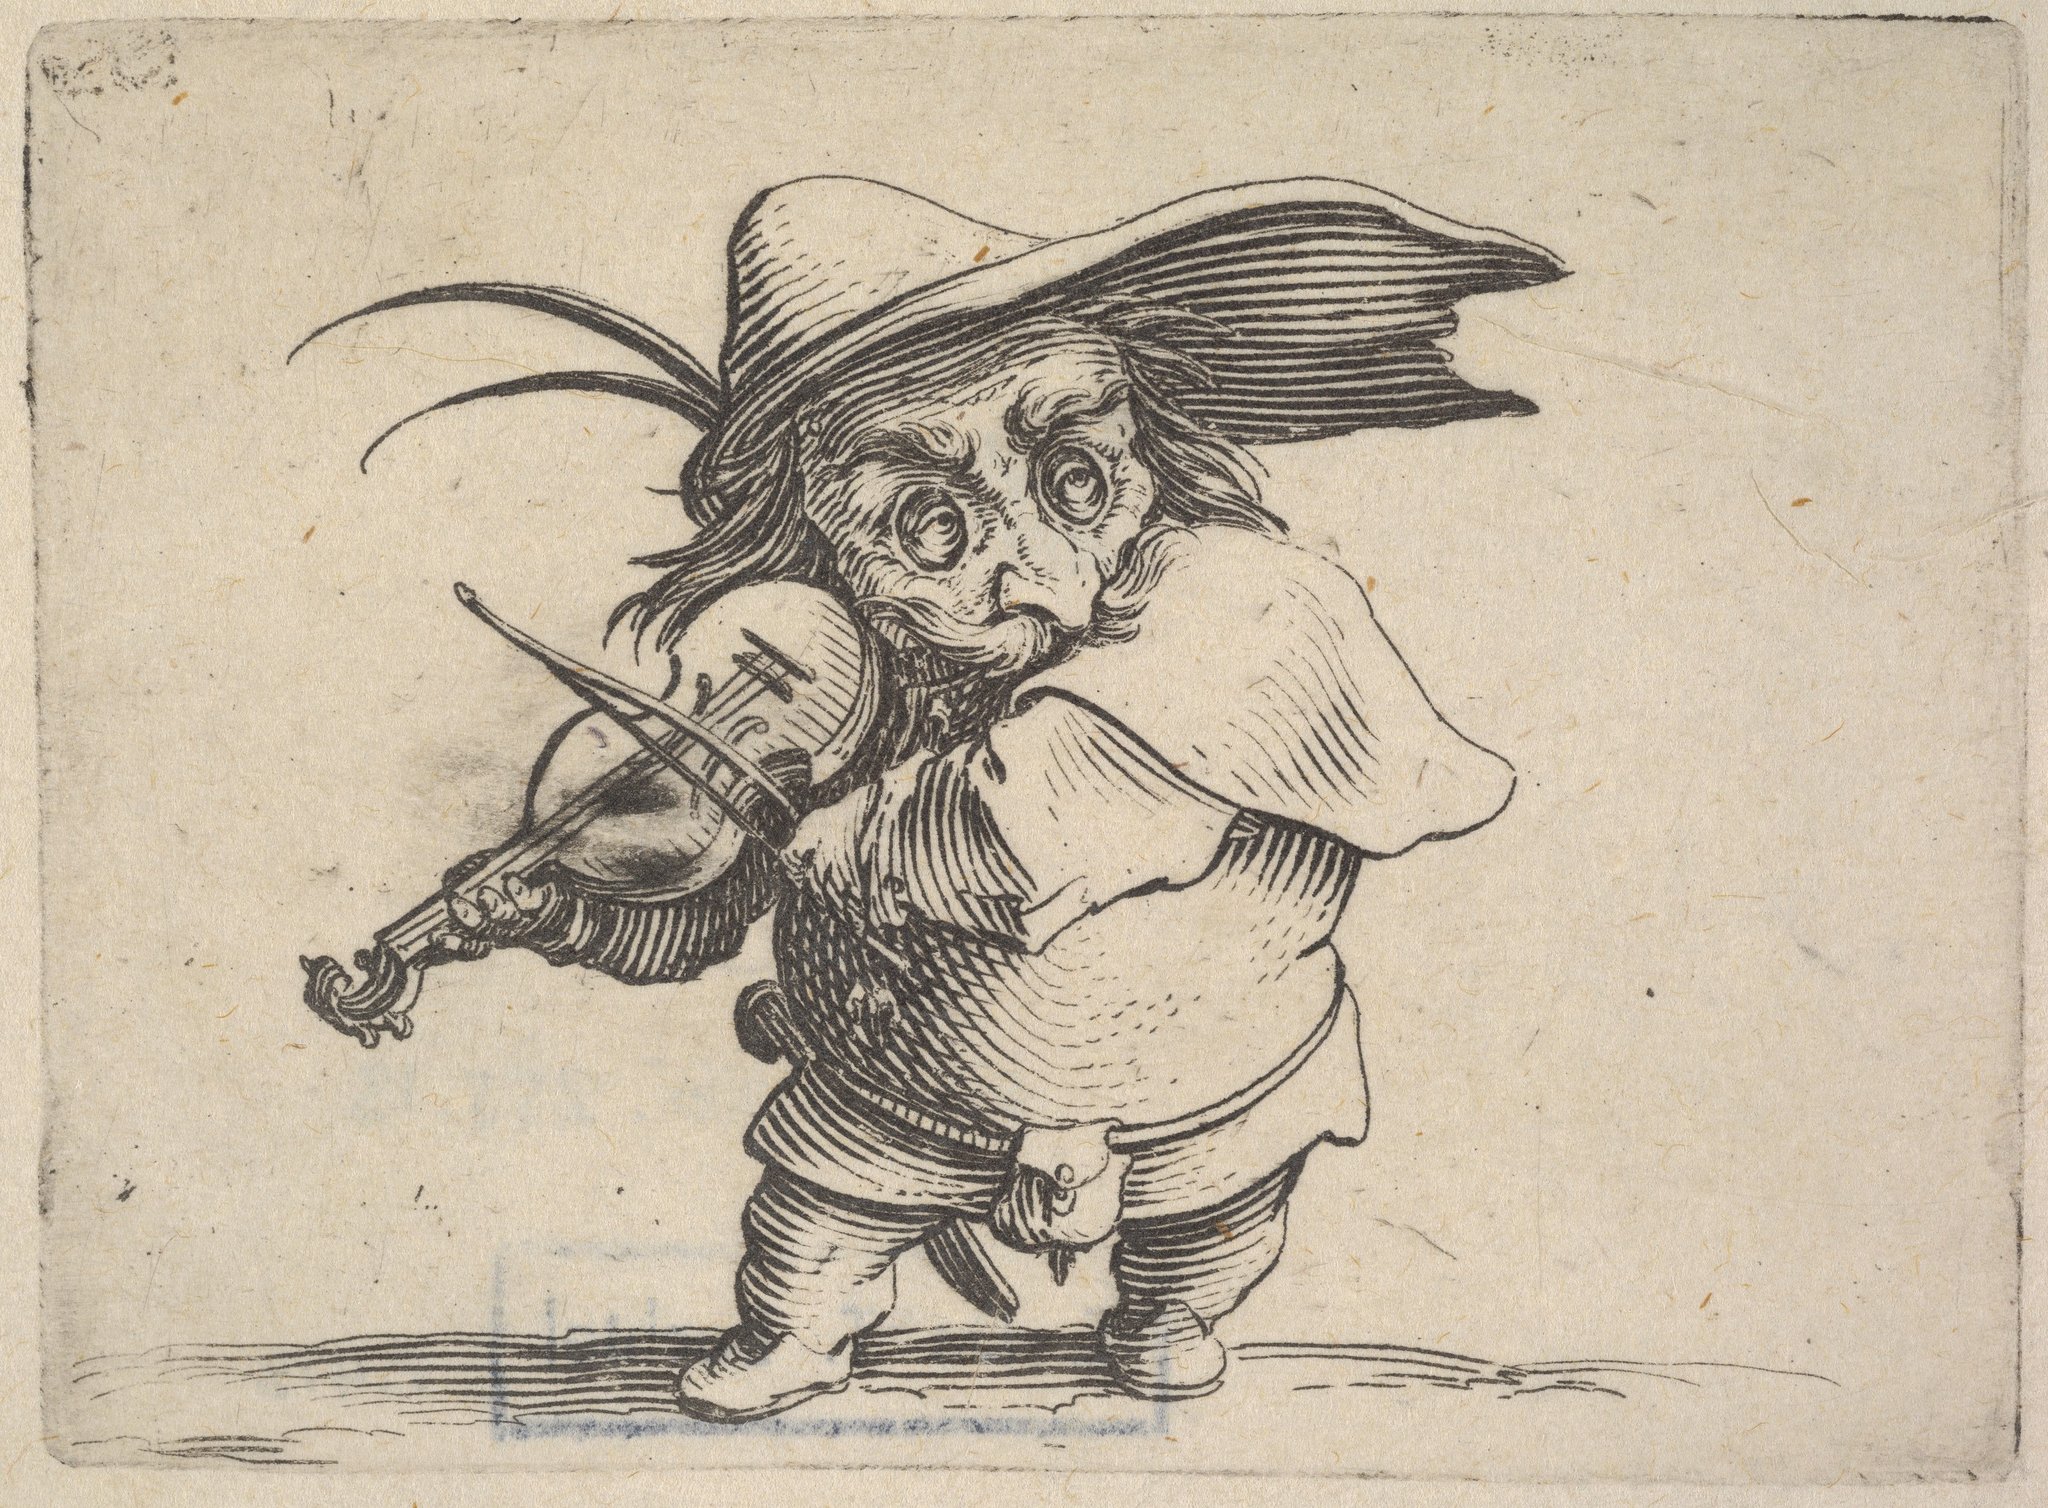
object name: print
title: Small, masked male figure playing a violin, from "Varie Figure Gobbi"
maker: jacques callot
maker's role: artist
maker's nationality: french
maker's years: 1592-1635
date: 1621-1625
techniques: etching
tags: men,violins